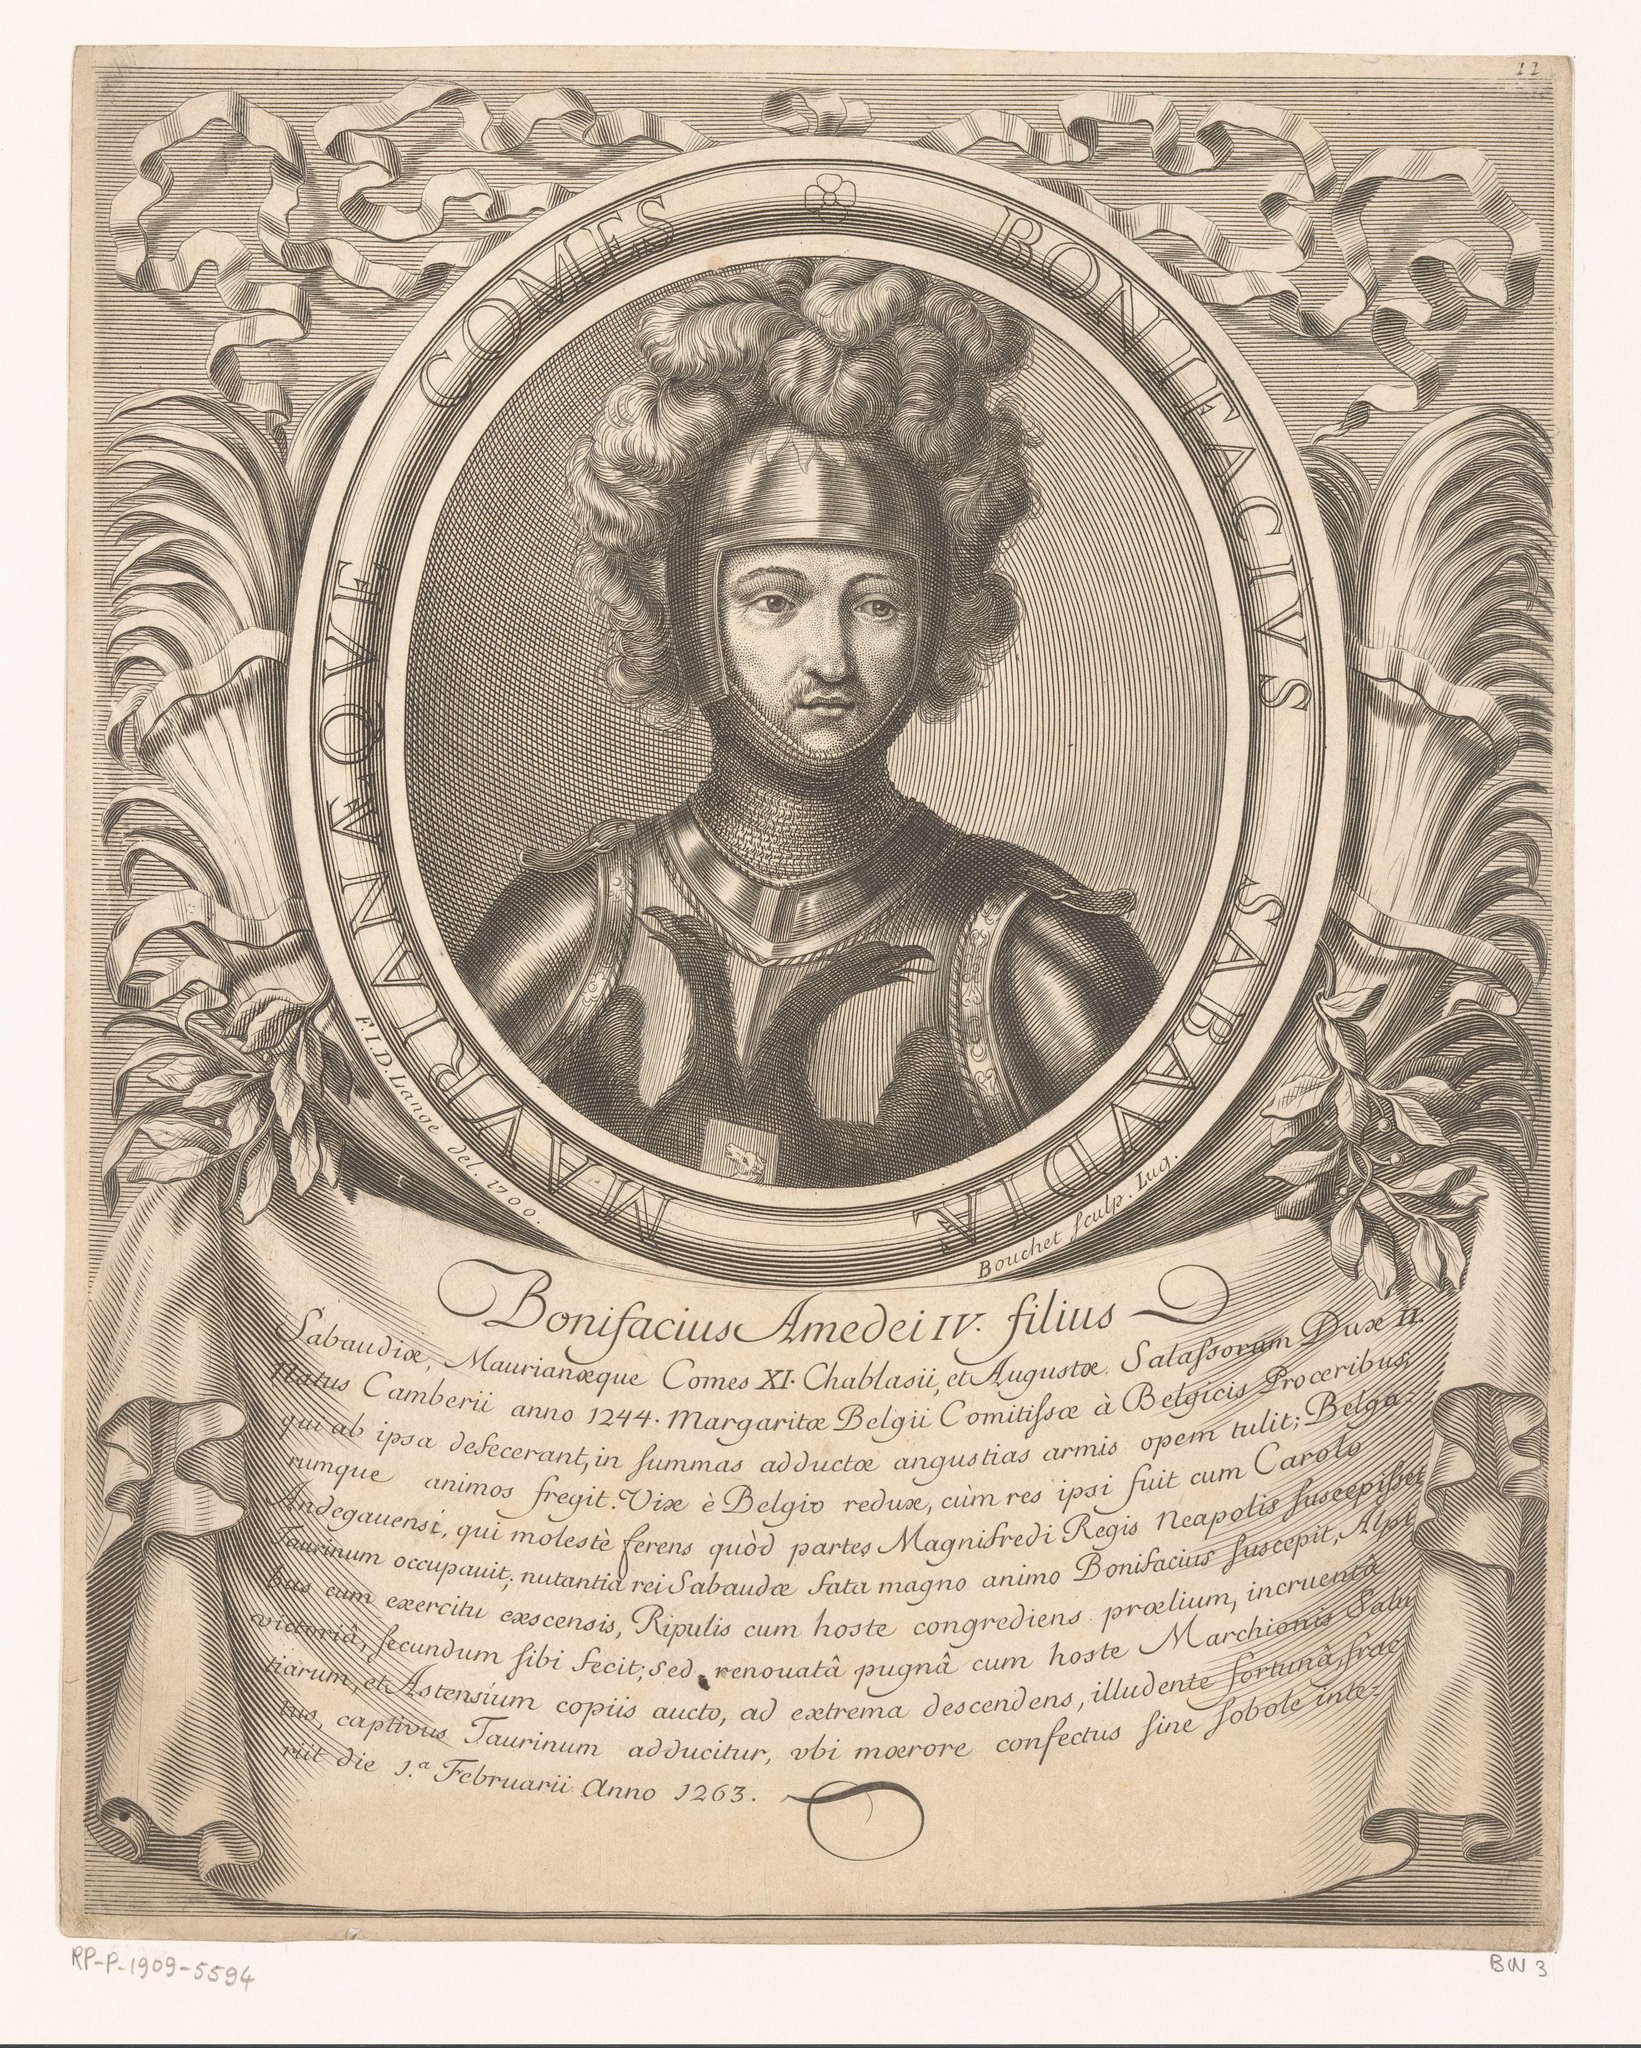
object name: print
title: Bonifacius Amedei IV. filius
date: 1700-1714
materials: paper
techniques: engraving, etching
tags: earl, helmet, cuirass, historical persons, nobility and patriciate; chivalry, knighthood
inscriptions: collector's mark: Lugt 2228